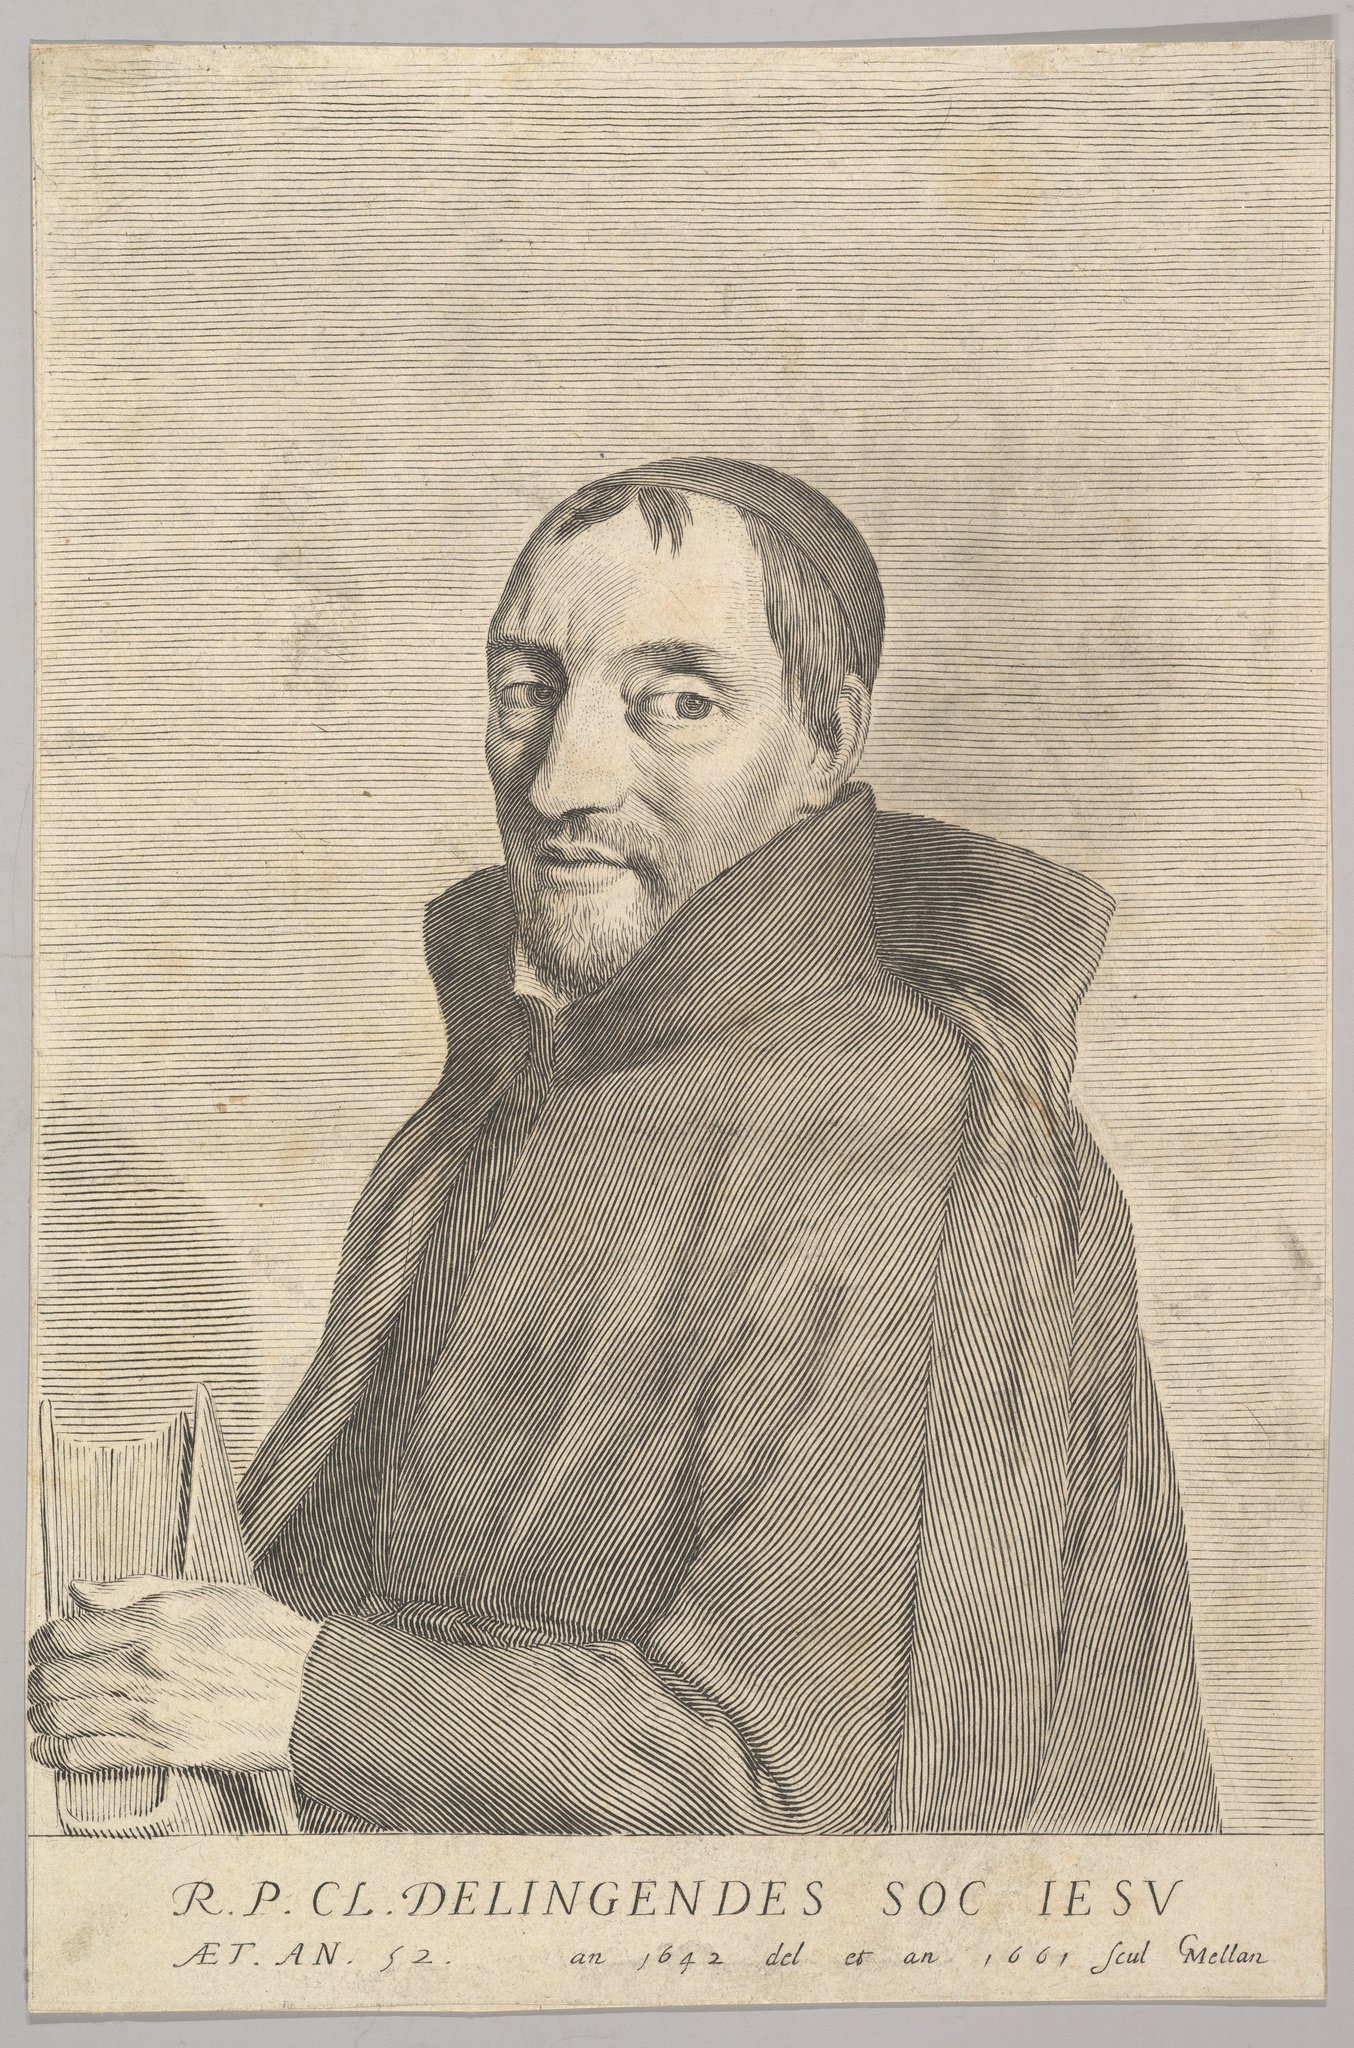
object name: print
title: Le Père Claude de Lingendes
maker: claude mellan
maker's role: artist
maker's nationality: french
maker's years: 1598-1688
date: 1661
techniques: engraving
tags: men,portraits